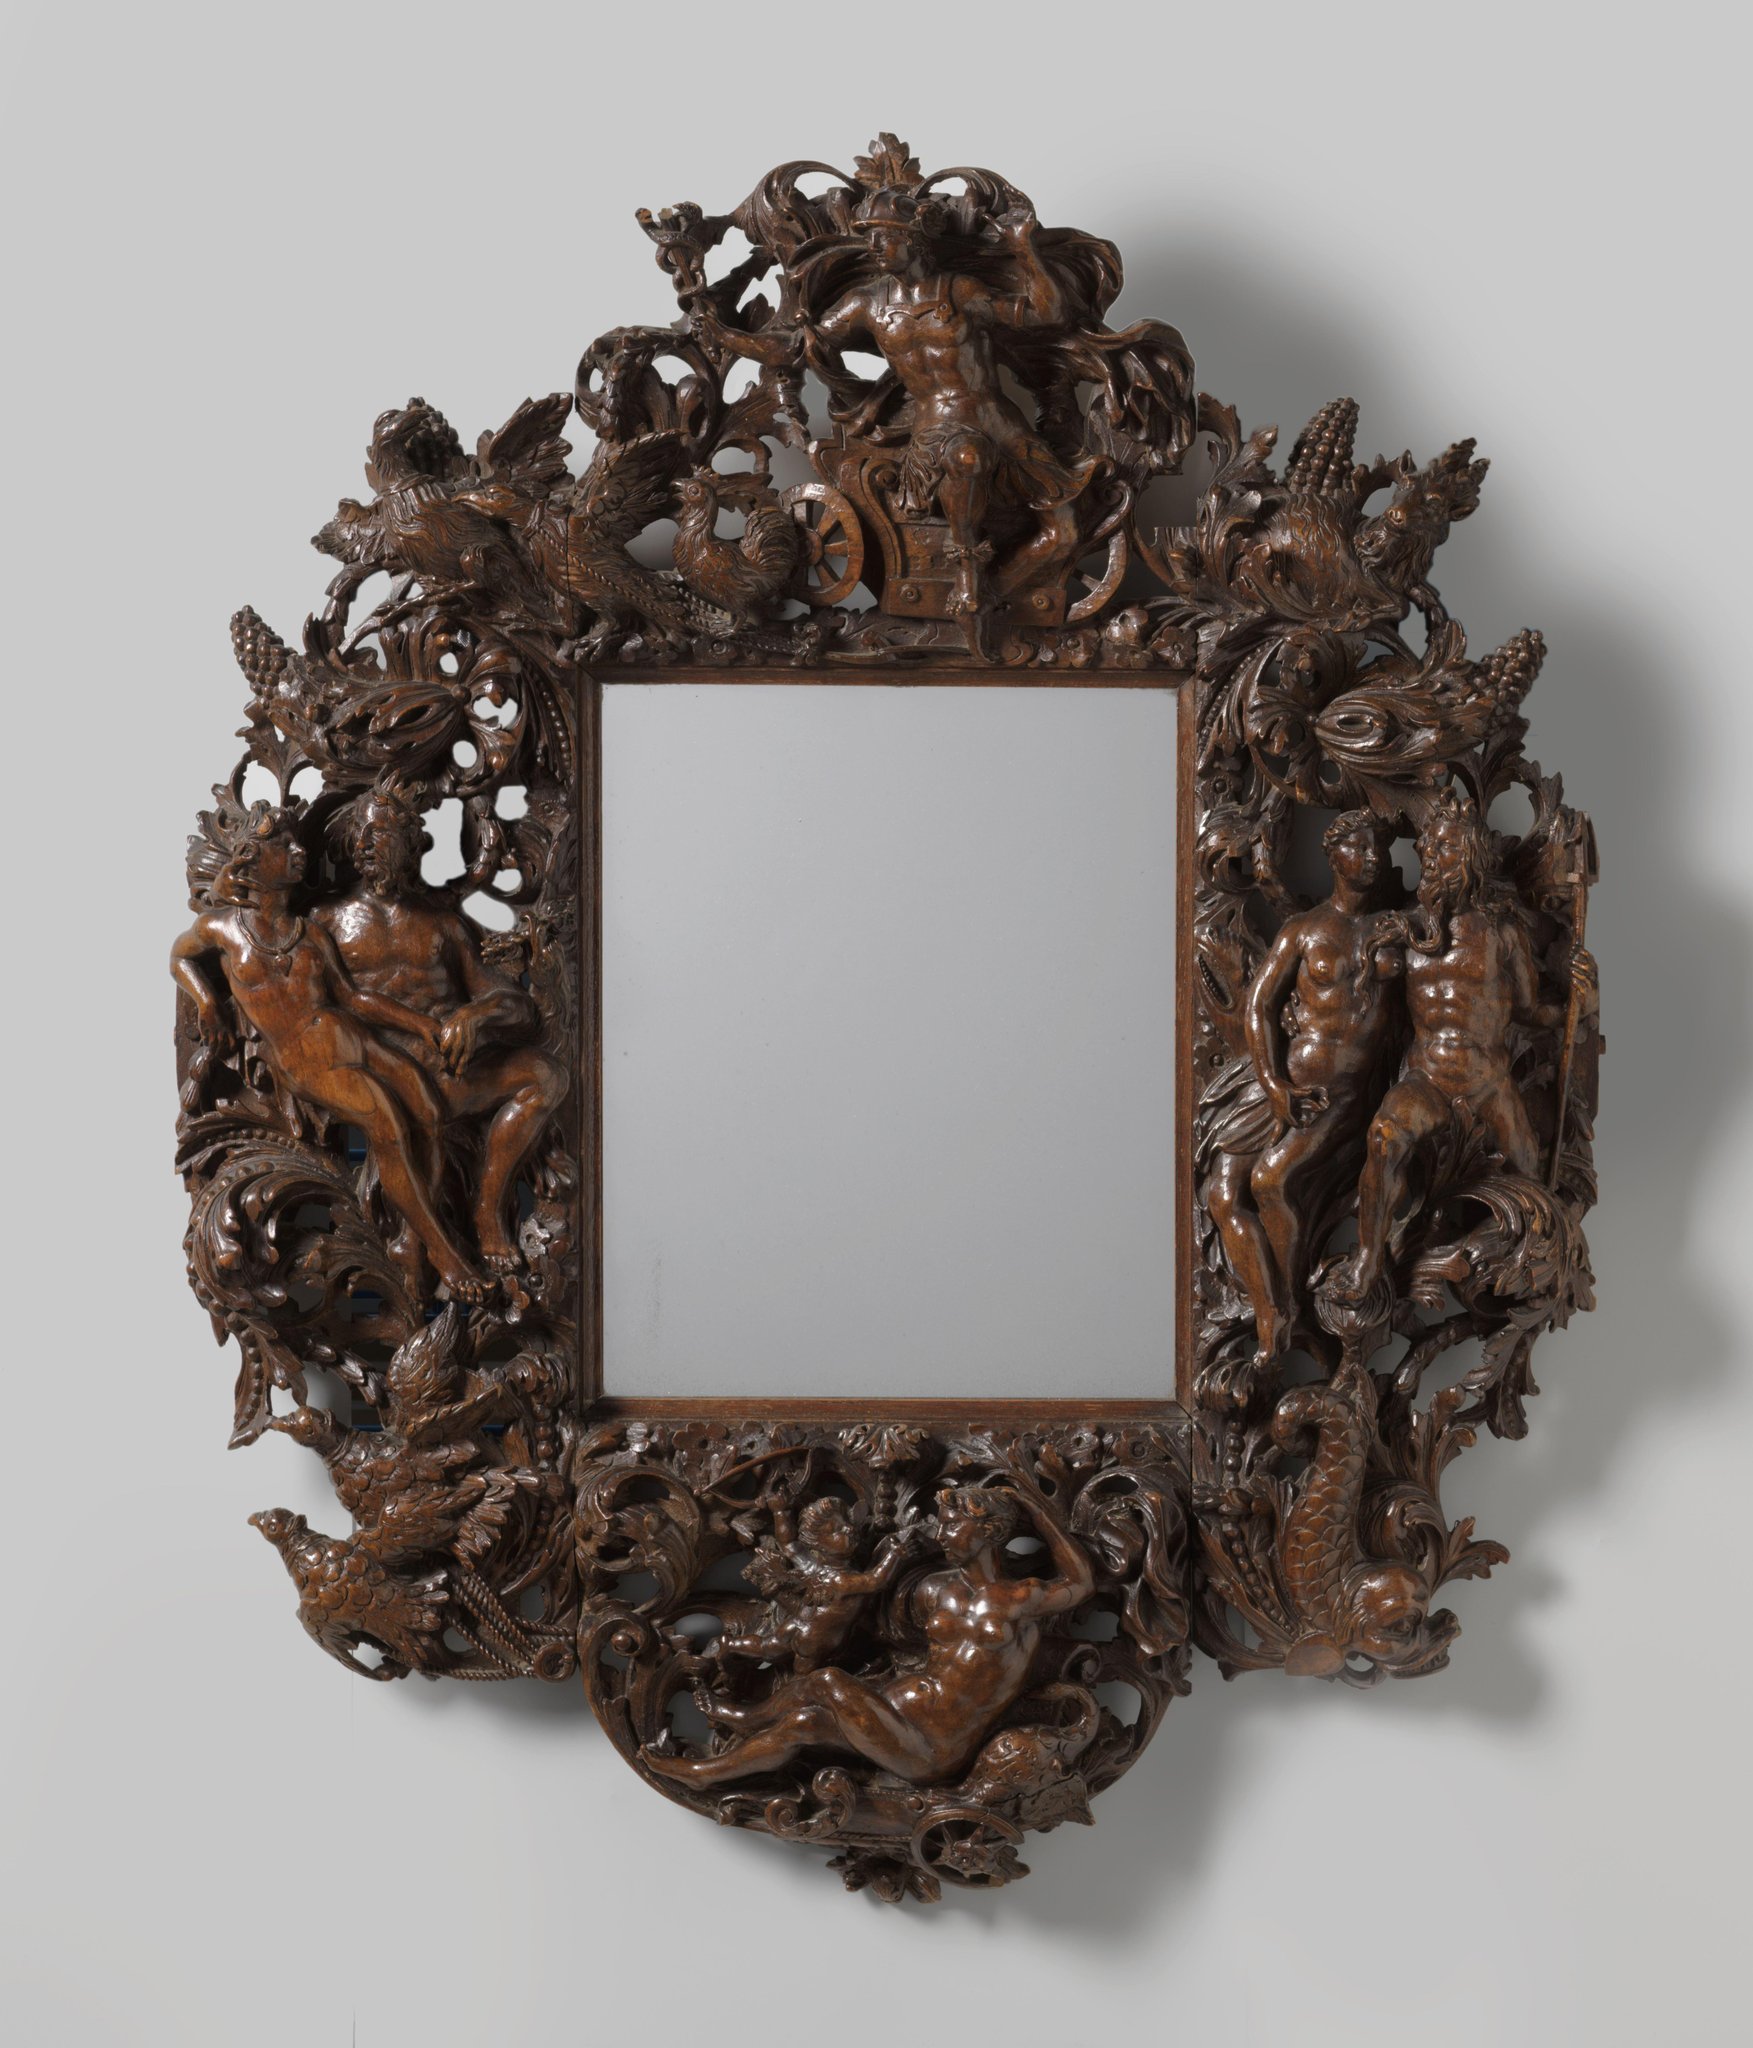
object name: spiegellijst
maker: Anonymous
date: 1675-1700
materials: amalgam, wood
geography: netherlands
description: Spiegellijst van notenhout, gebeeldhouwd met bladeren en bloemen waarop midden boven Mercurius op een wagen, midden onder Venus en Amor op een wagen, te linker zijde Jupiter en Juno en te rechter zijde Neptunus en Amphitrite; in de linker bovenhoek twee adelaars (vuur?), in de rechter bovenhoek een geitebok (aarde?), in de rechter onderhoek een dolfijn (water?) en in de linker onderhoek twee vogels (lucht?). De binnenlijst is nieuw. Nederland, derde kwart 17de eeuw.